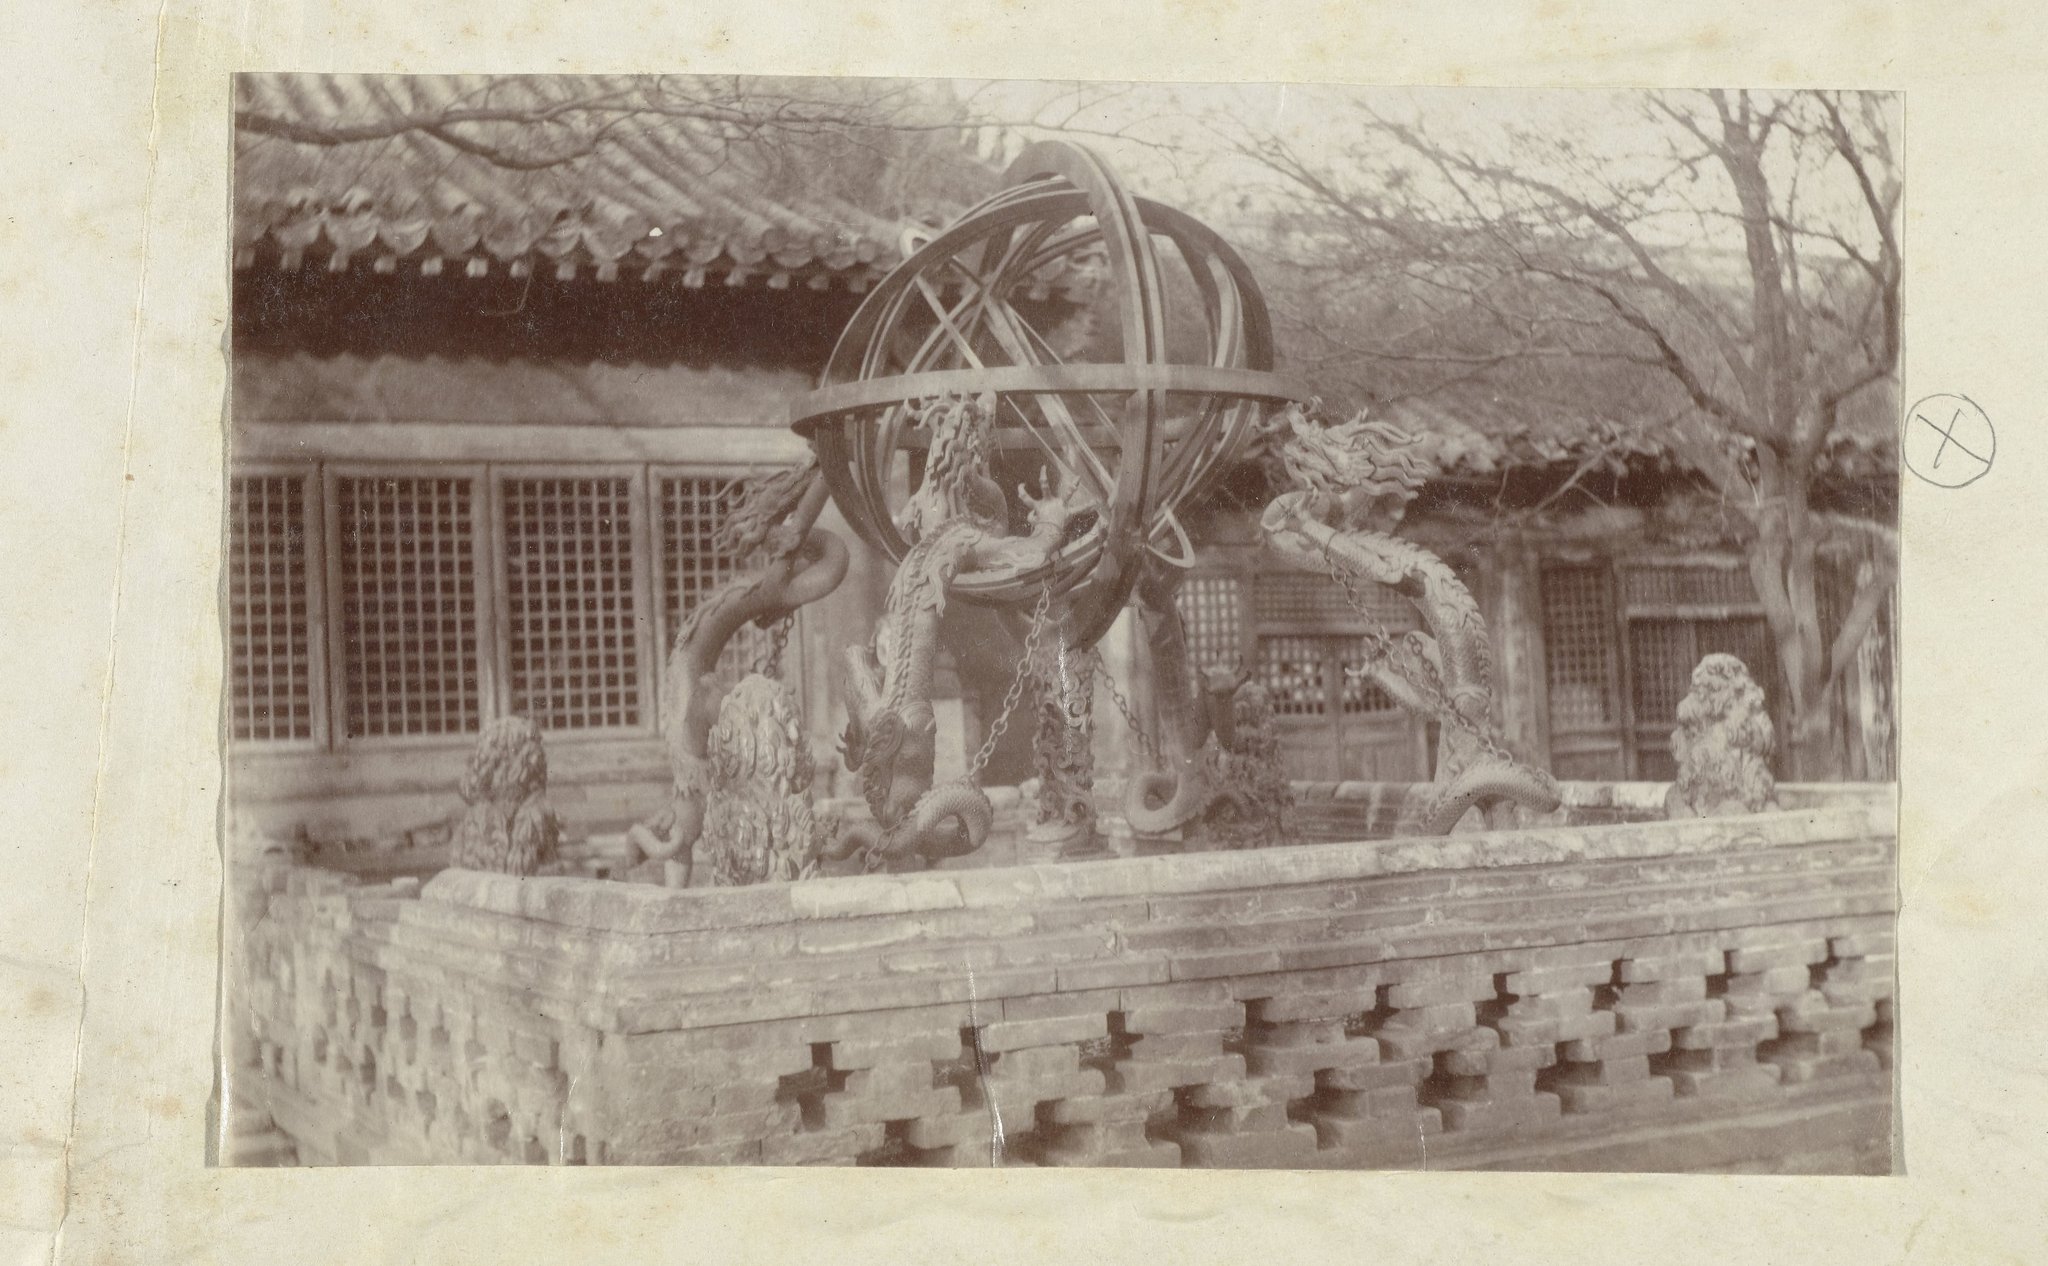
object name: photograph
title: Astronomische instrumenten bij het oude observatorium van Beijing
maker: Anonymous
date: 1879-1890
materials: paper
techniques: albumen print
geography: beijing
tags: observatory (~ astronomy), astronomical instruments